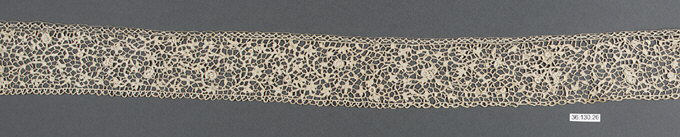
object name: border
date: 1601-1800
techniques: lace